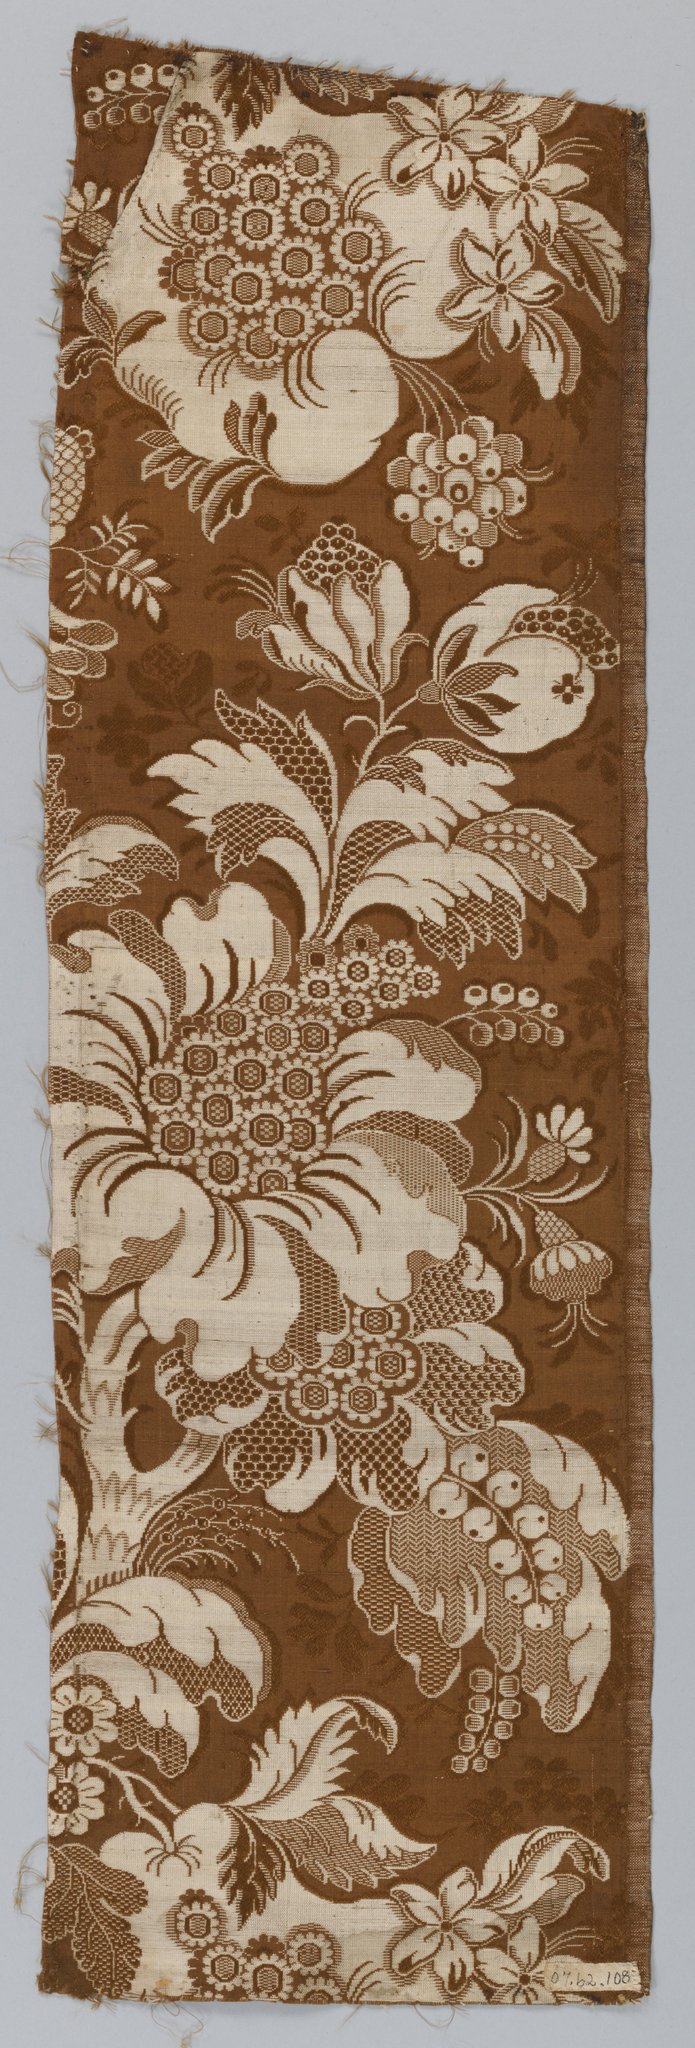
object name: piece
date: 1733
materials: silk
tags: flowers,leaves